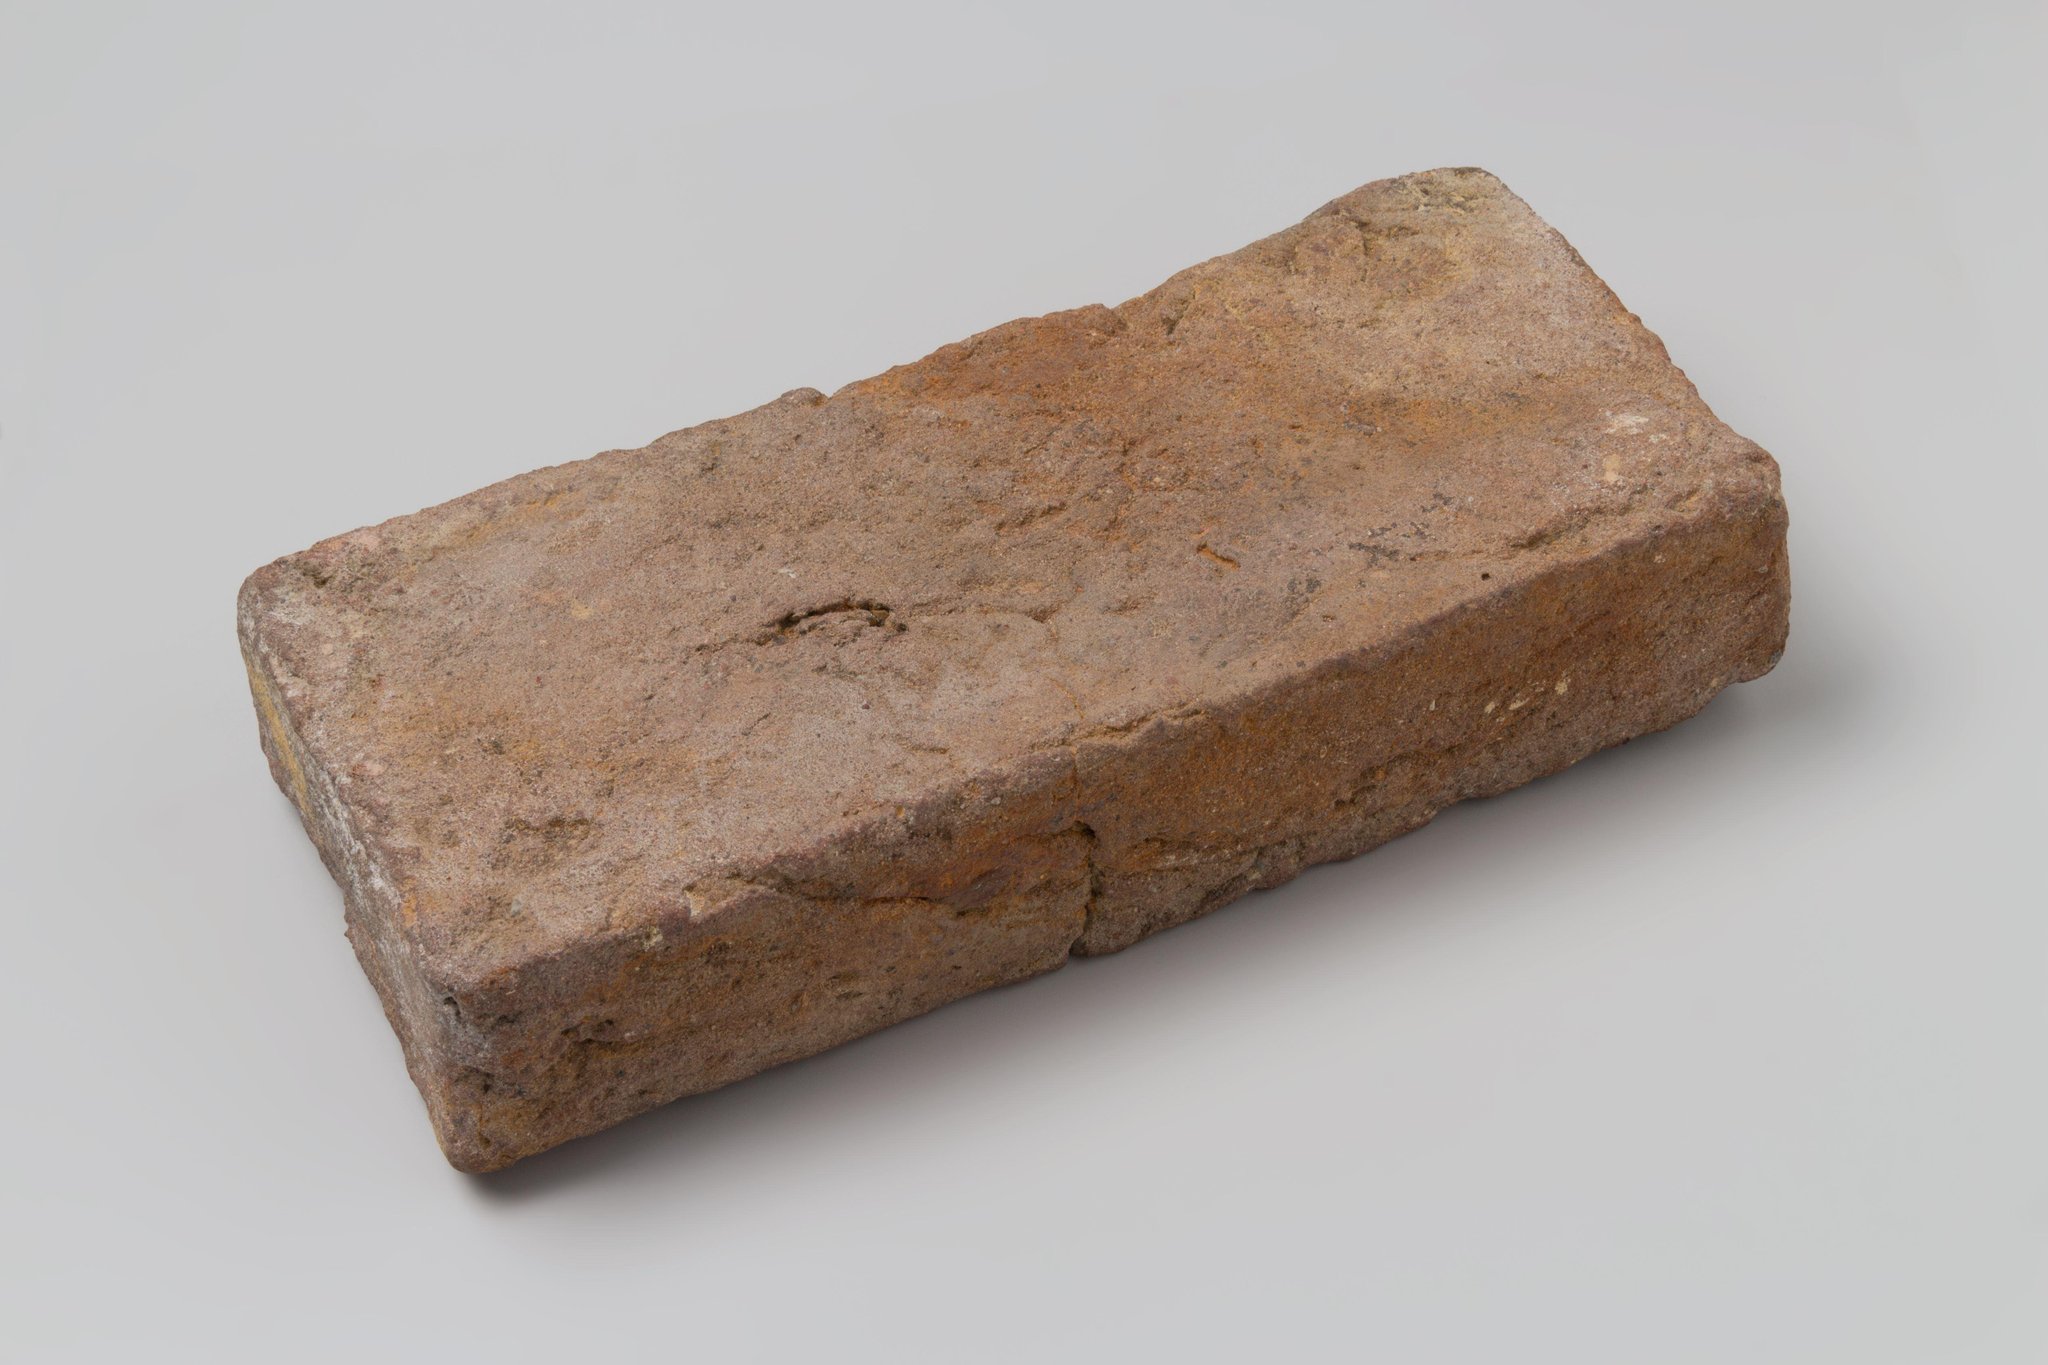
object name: brick clay product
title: Baksteen uit het wrak van de Oost-Indiëvaarder 't Vliegend Hart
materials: brick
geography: netherlands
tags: 't vliegend hart (schip), verenigde oostindische compagnie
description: Hele roodbruine baksteen, rechthoekig, oblong. Brick.